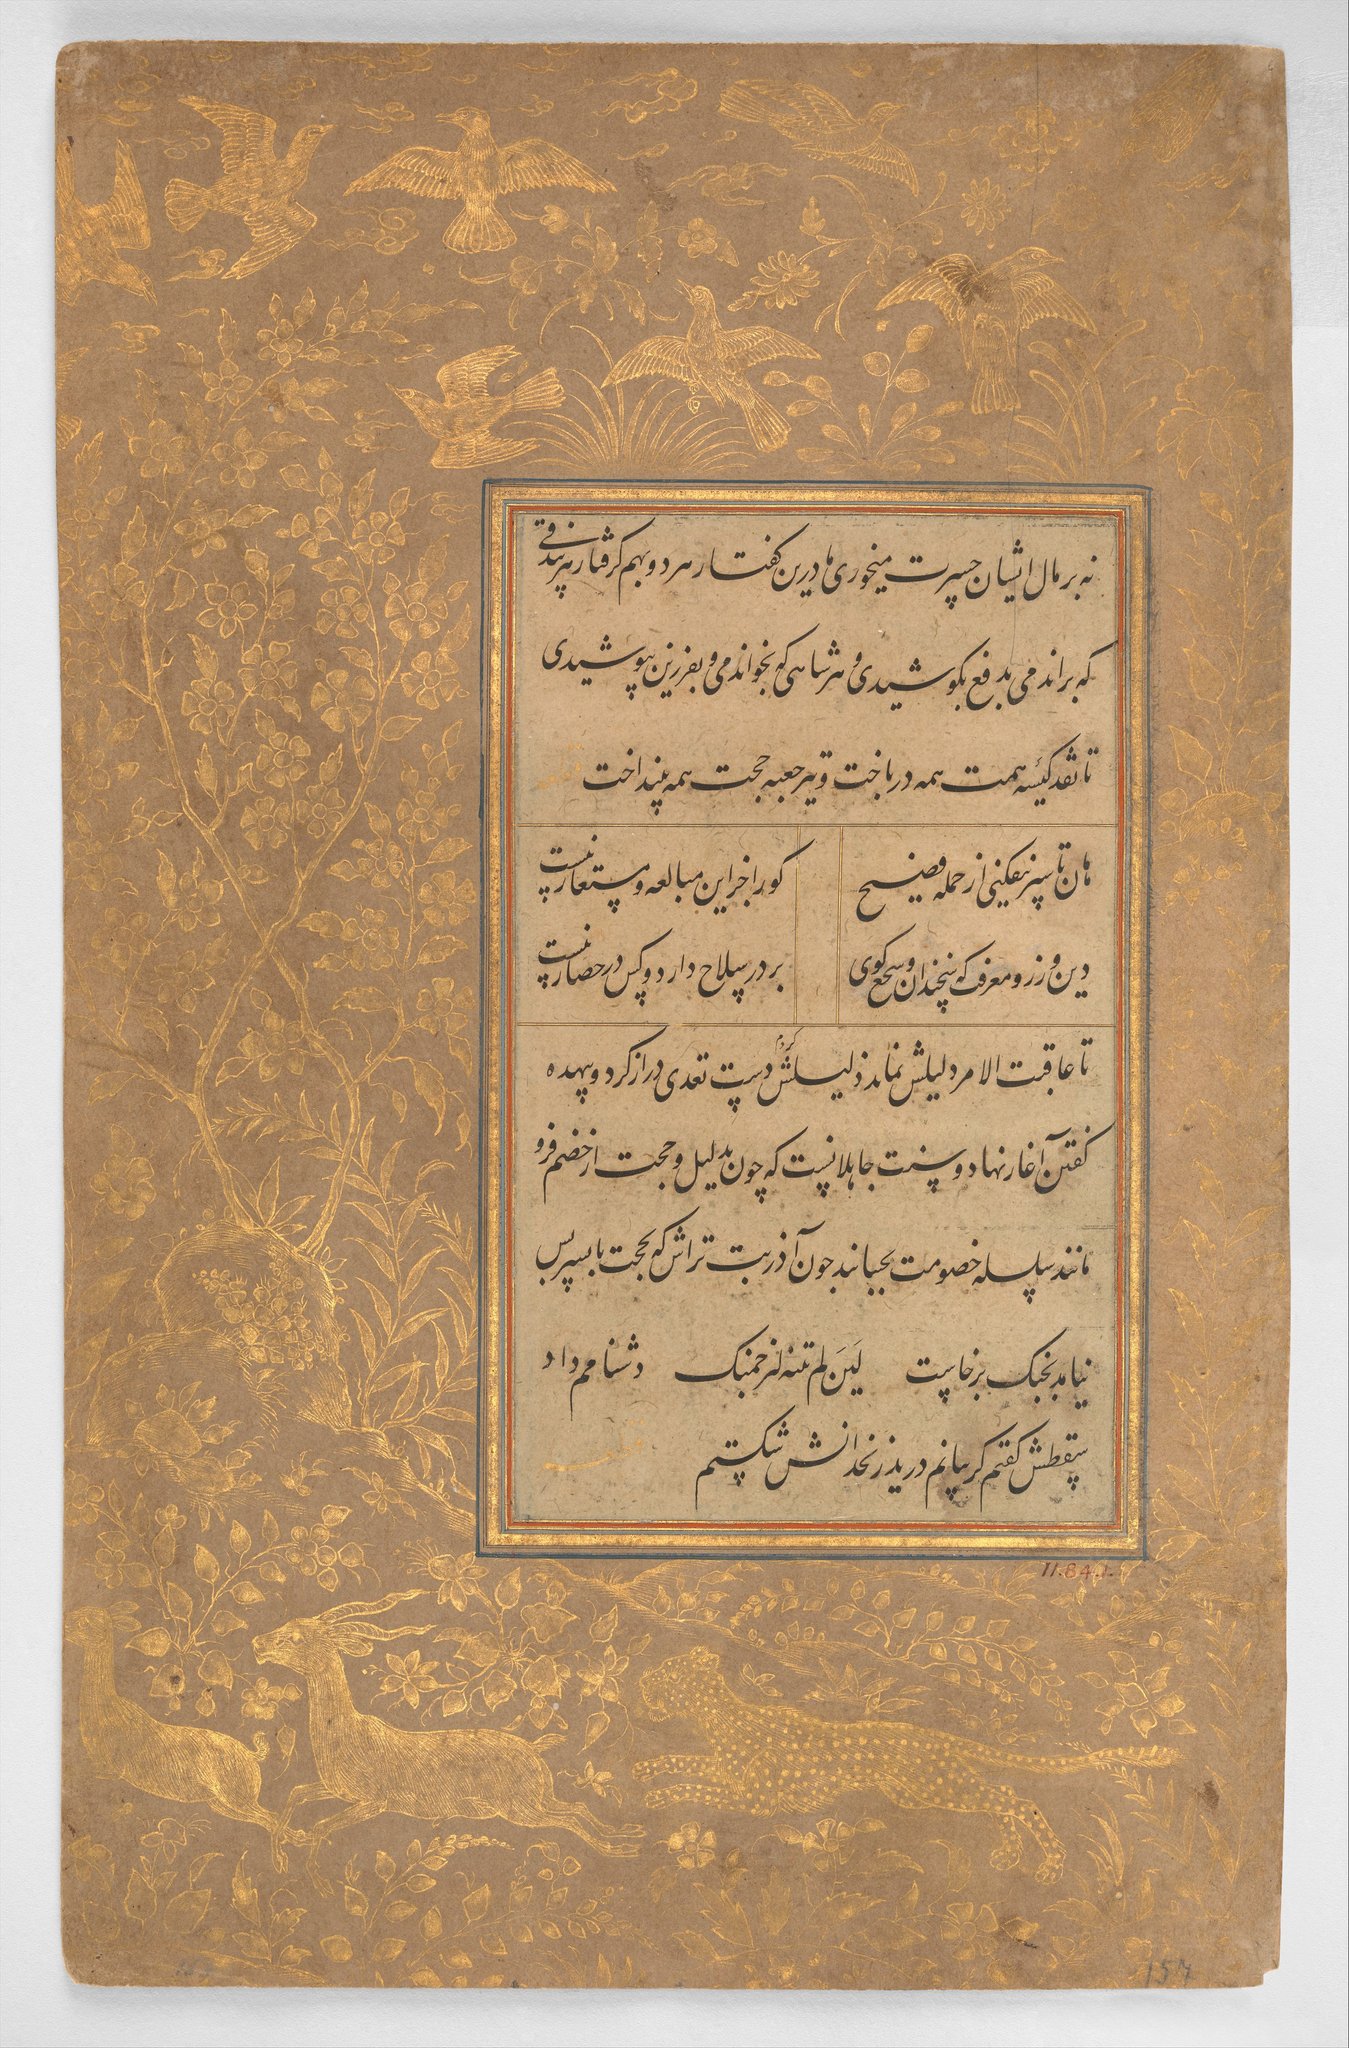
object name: folio from a non illustrated manuscript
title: Page of Calligraphy from an Anthology of Poetry by Sa`di and Hafiz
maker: sa'di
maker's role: author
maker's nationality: iranian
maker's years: 1213-1291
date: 1467-1500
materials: gold, ink, paper, watercolor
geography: afghanistan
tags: animals,birds,poetry,deer,calligraphy